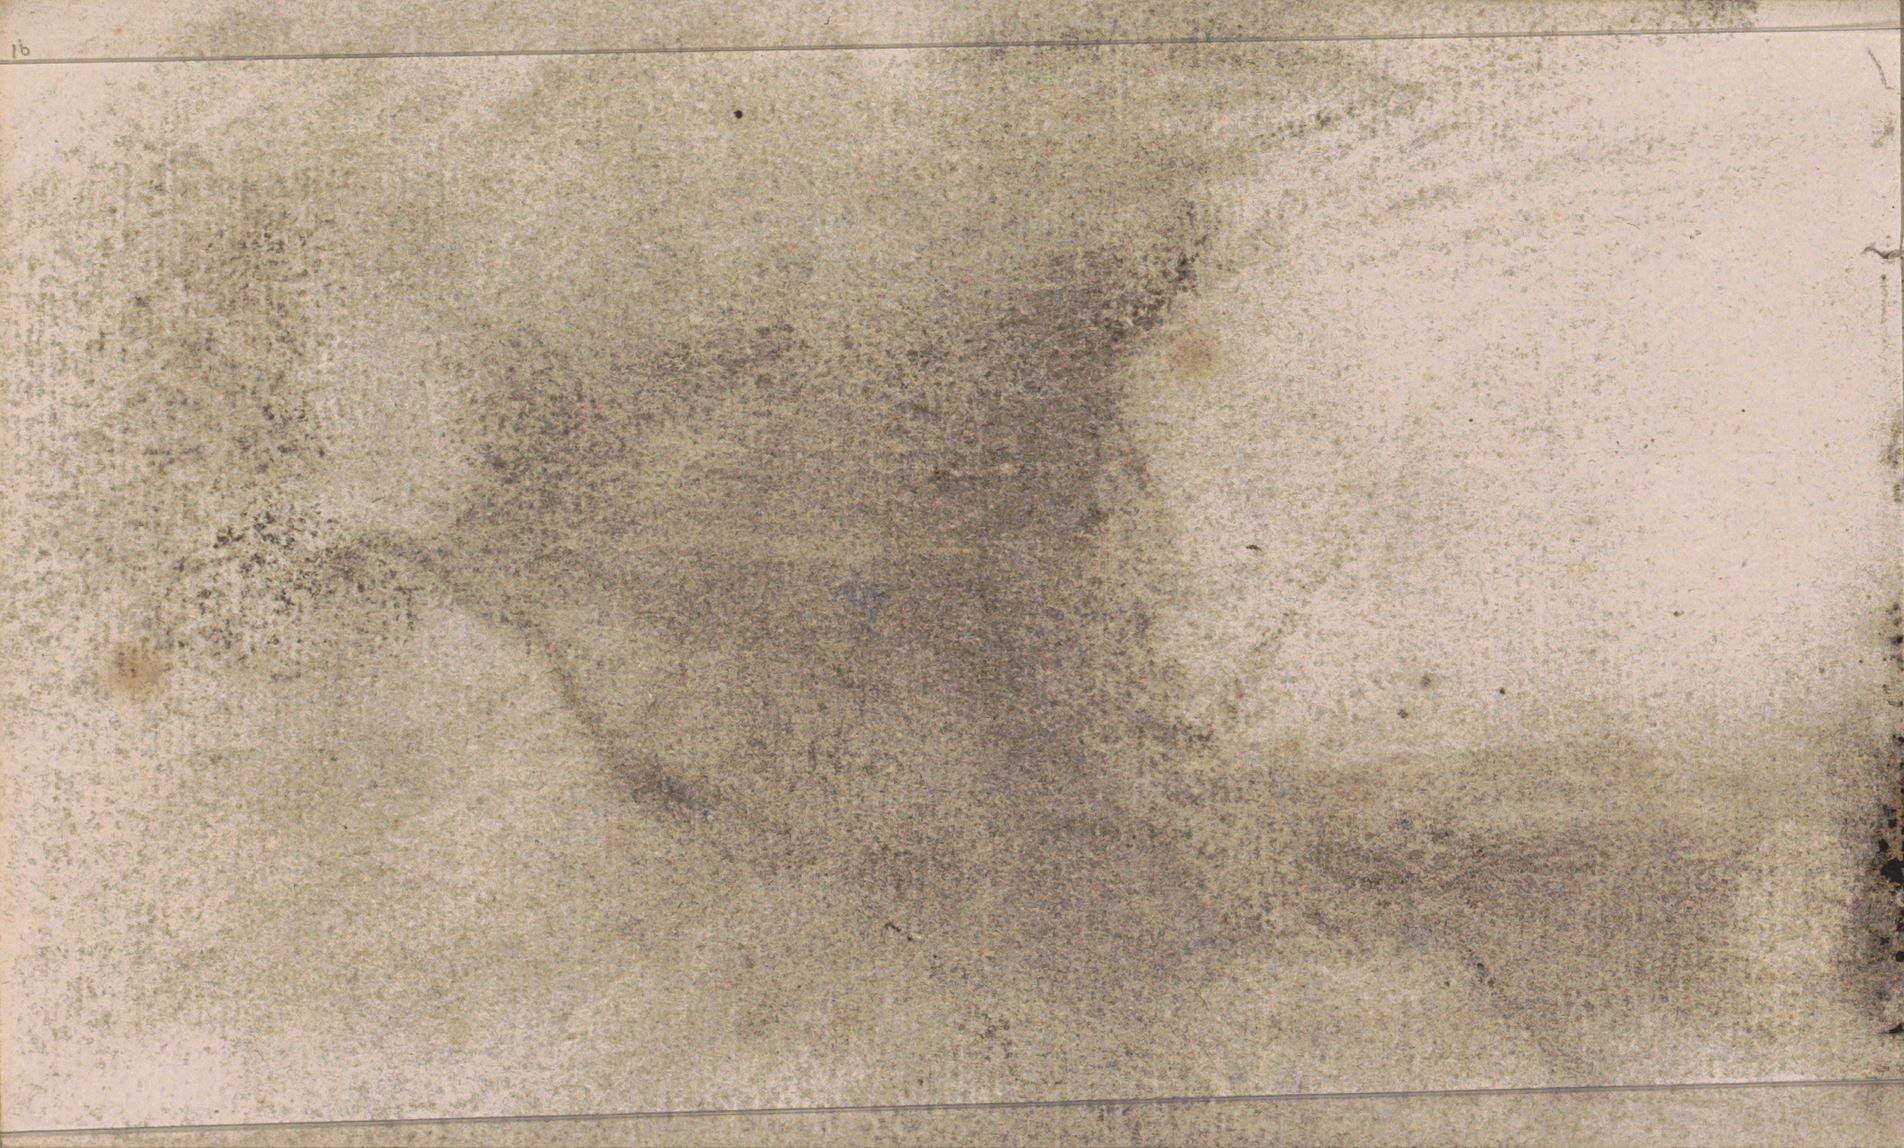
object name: sketchbook leaf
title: Abklatsch van de krijttekening op pagina 17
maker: isaac israels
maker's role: draughtsman, painter, print maker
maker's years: 1865-1934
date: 1875-1934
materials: paper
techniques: printmaking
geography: the hague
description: Pagina 16 uit schetsboek XLVIII met 62 pagina's.